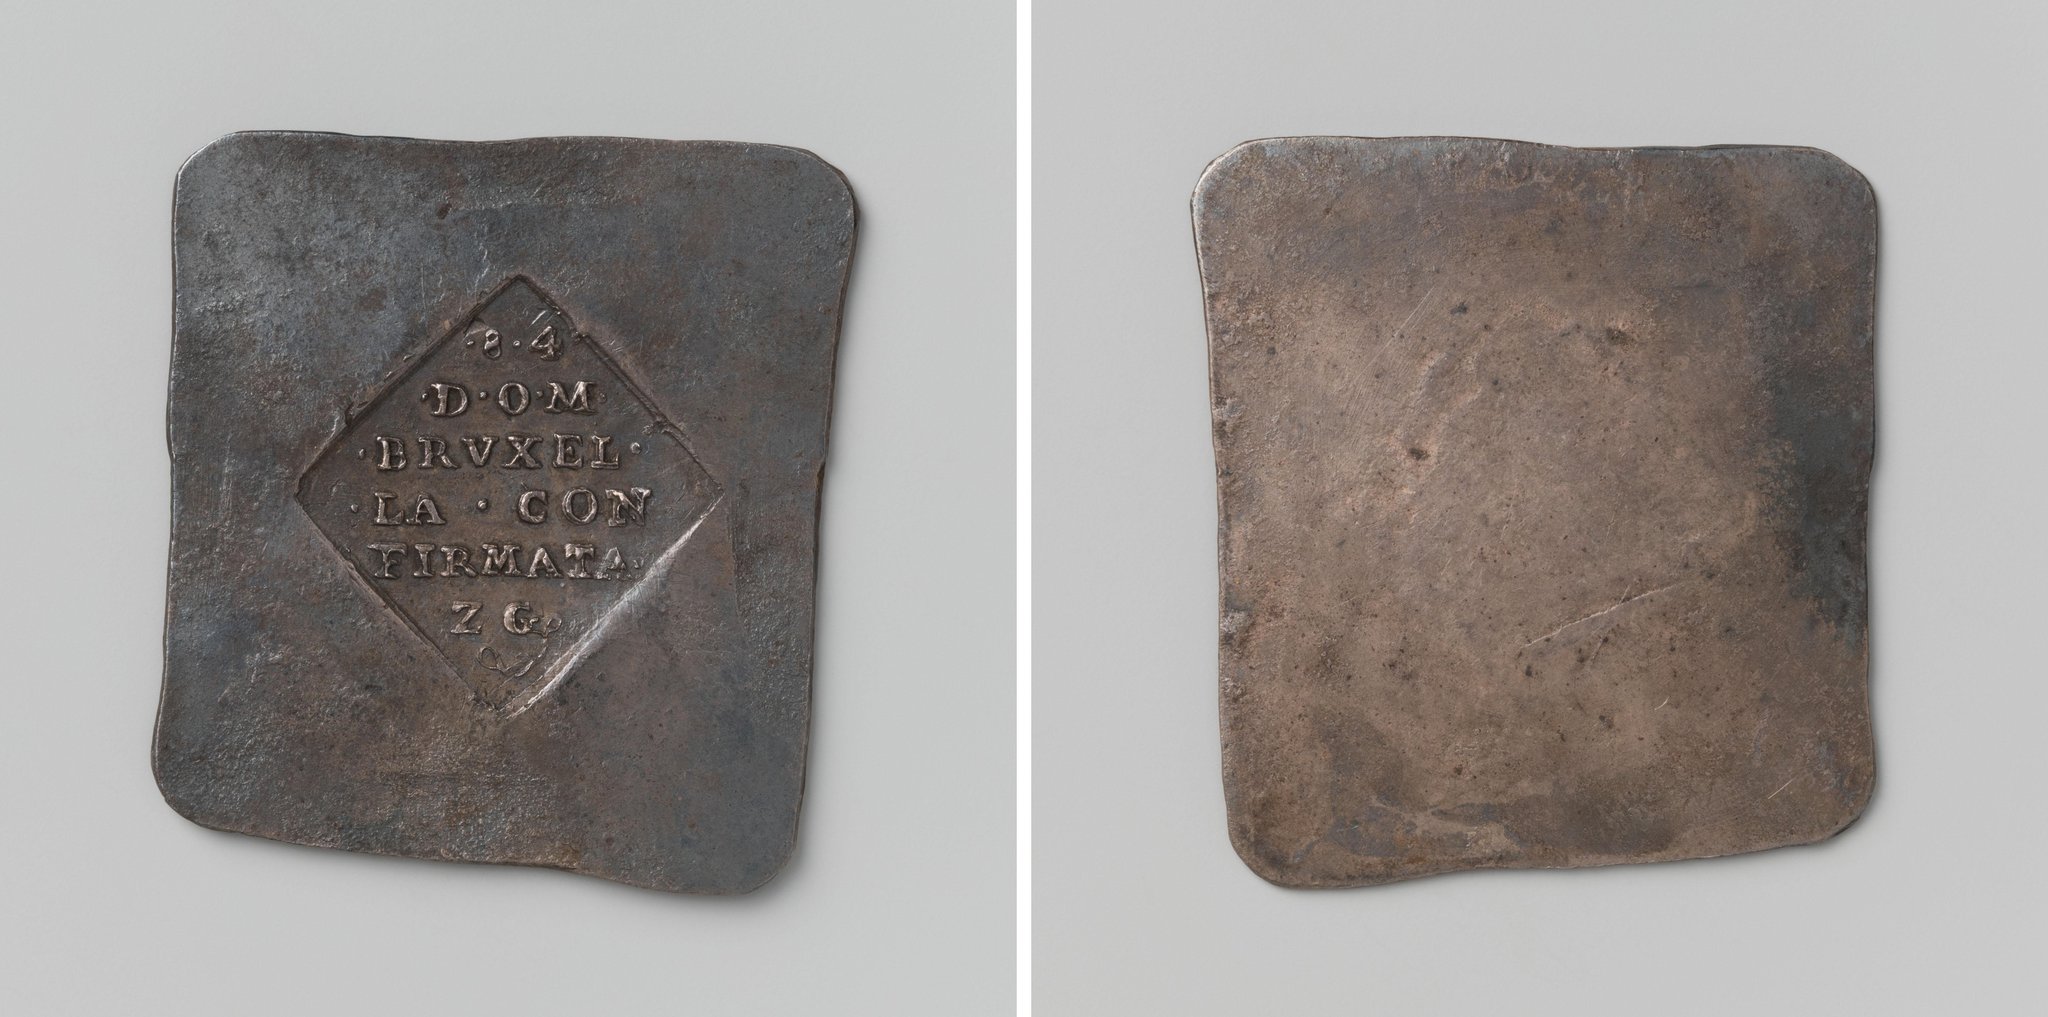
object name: siege coin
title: Tweegulden, noodmunt uit Brussel, vervalsing van een noodmunt geslagen tijdens het beleg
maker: Anonymous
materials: silver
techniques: striking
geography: belgium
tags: brussels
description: Eenzijdige, rechthoekige zilveren noodmunt. Voorzijde: een ruitvormige stempel: opschrift. Keerzijde: blanco.